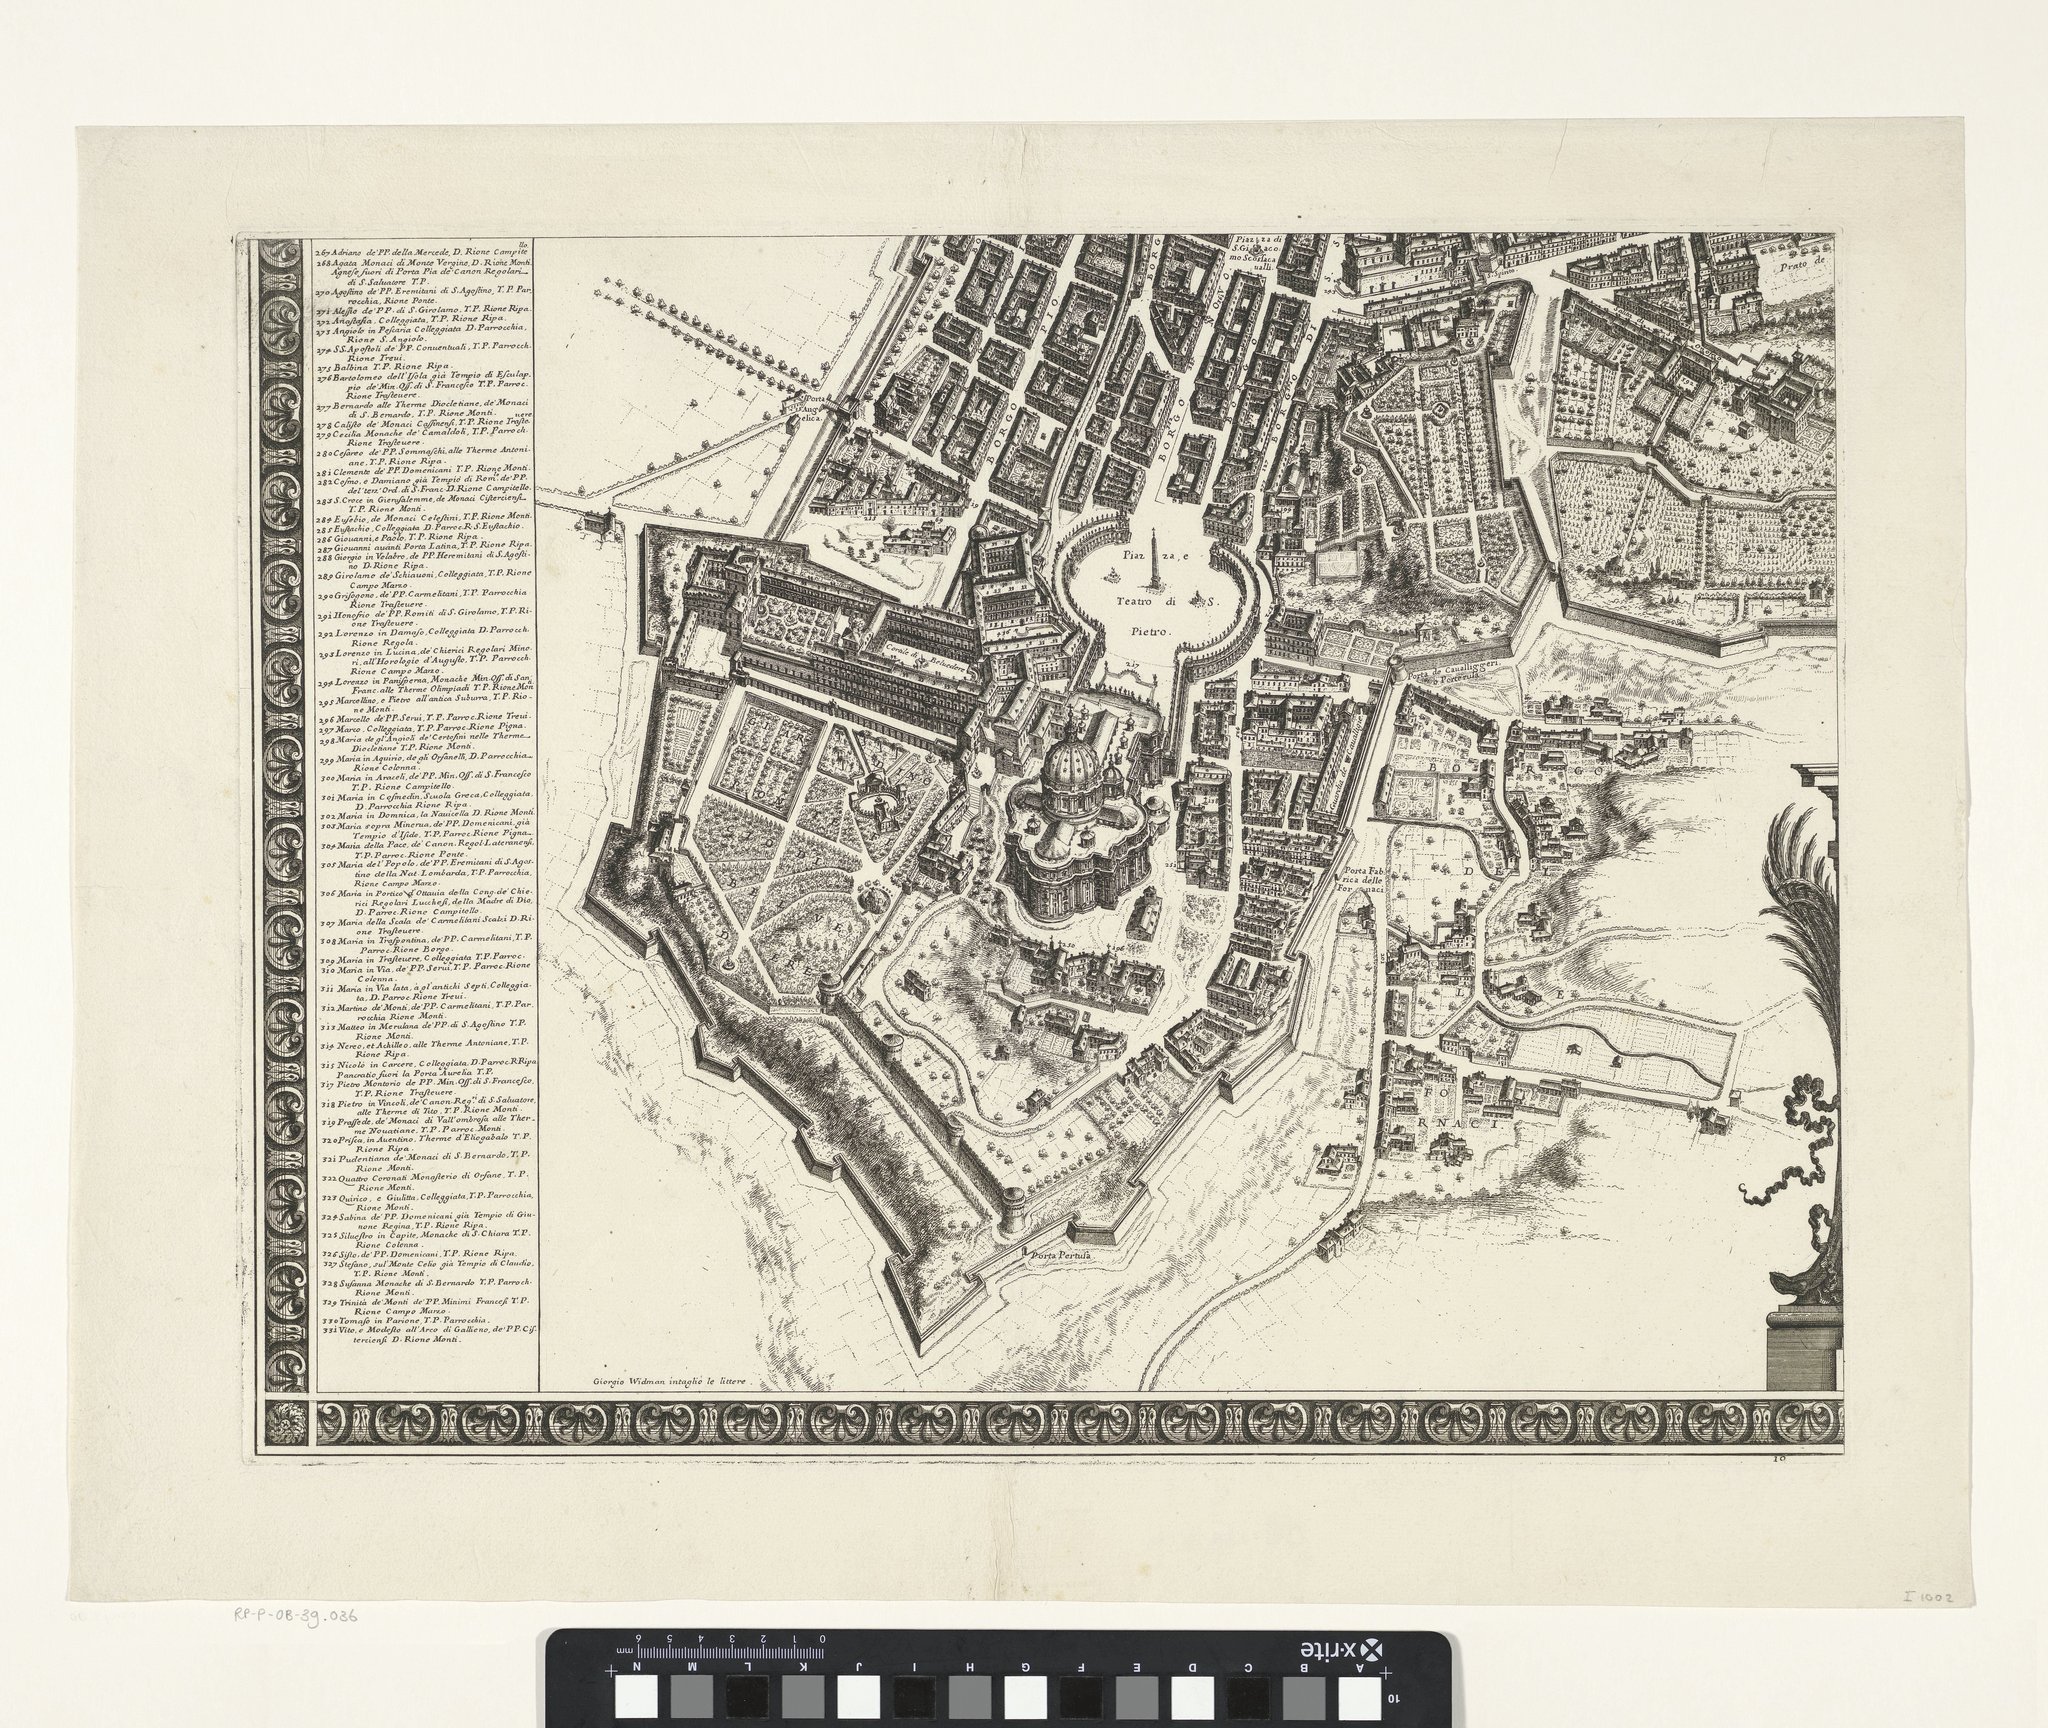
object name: print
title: Nuova piante et alzata della città di Roma con tutte le strade piazze et edificii (...)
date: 1676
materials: paper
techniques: etching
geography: vatican city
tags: maps, atlases, rome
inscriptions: collector's mark: Lugt 2228